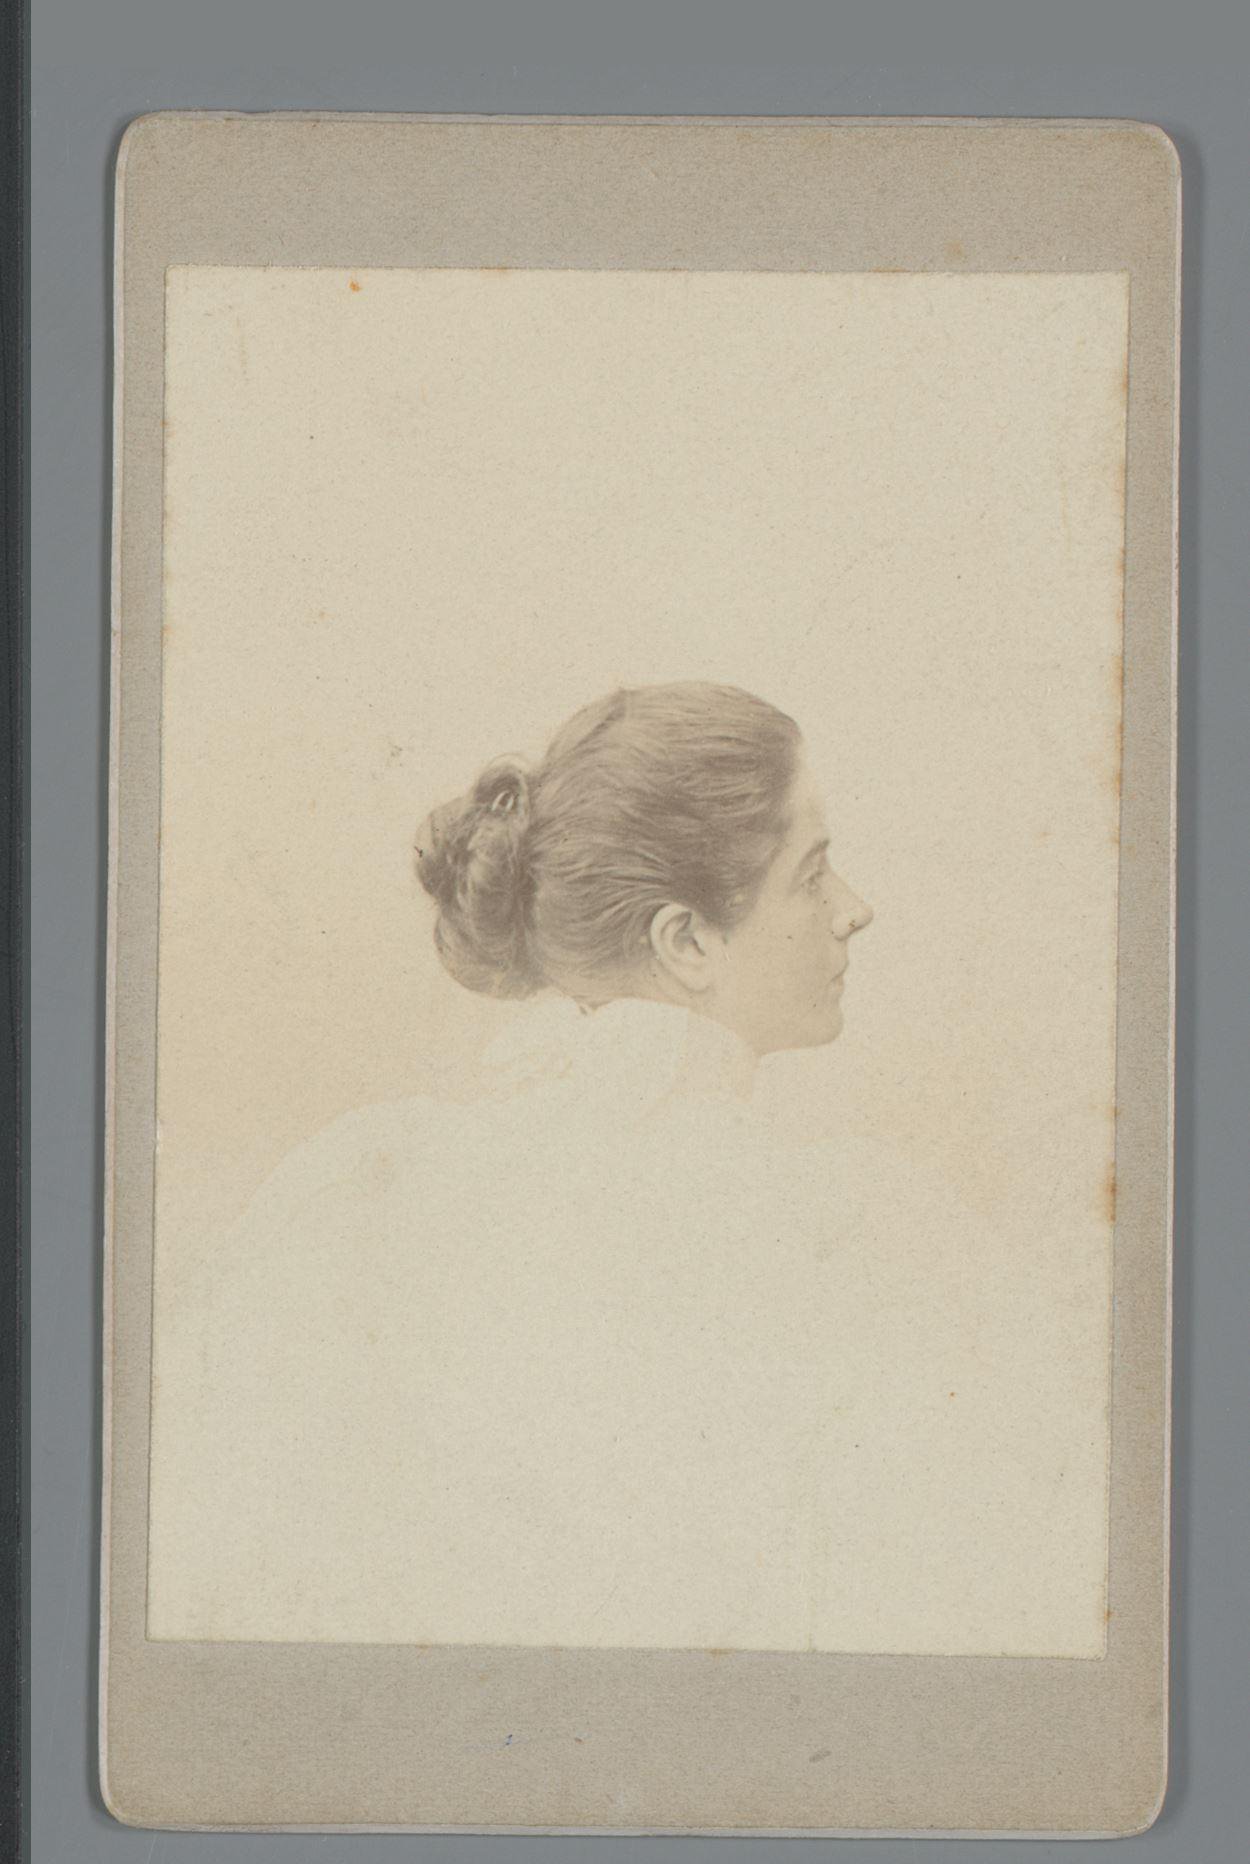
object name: carte de visite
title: Portret van Cornelia Hendrika Jonker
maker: Anonymous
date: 1880-1920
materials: cardboard, photographic support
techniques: gelatin silver print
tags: cornelia hendrika jonker, historical persons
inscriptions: name: ‘C.H. Jonker’